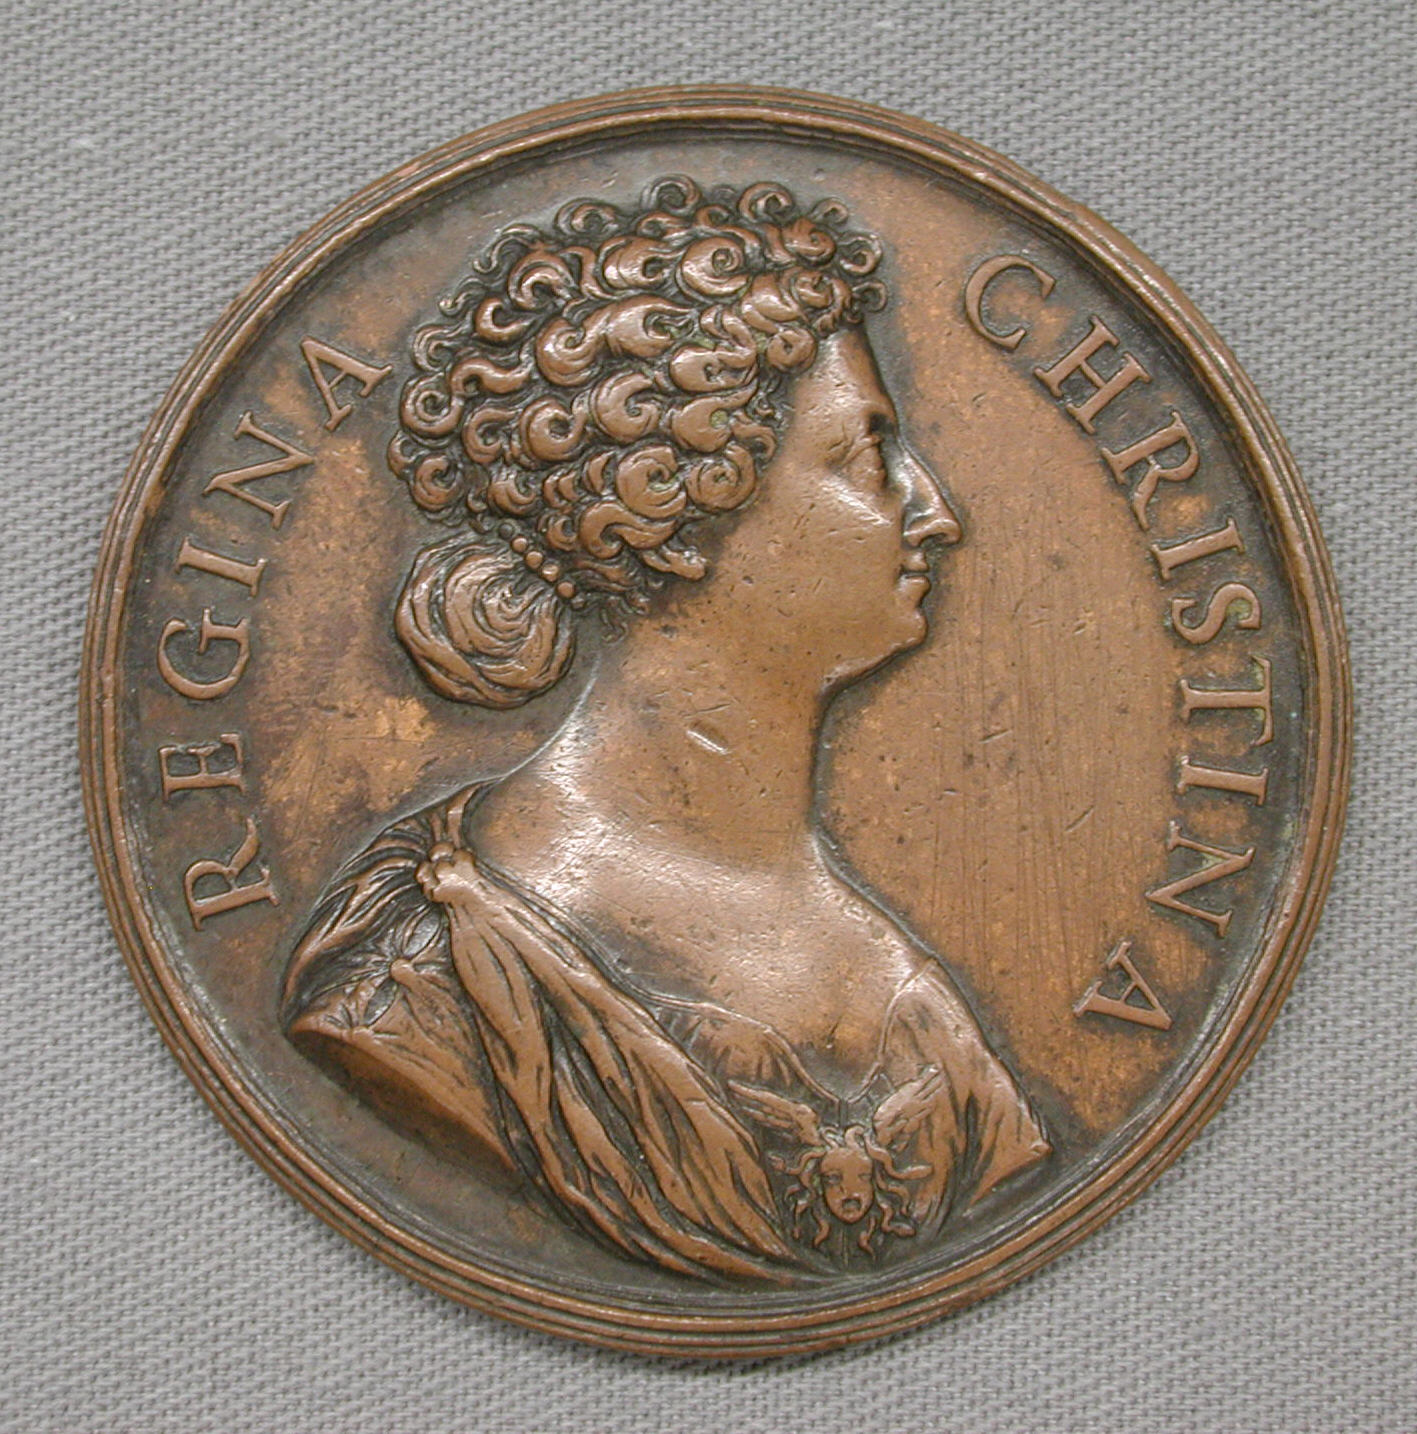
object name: medal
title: Conversion of Queen Christina of Sweden, 1654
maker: alberto hamerani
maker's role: artist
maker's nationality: italian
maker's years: 1620-1677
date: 1601-1700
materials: bronze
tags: queens,profiles